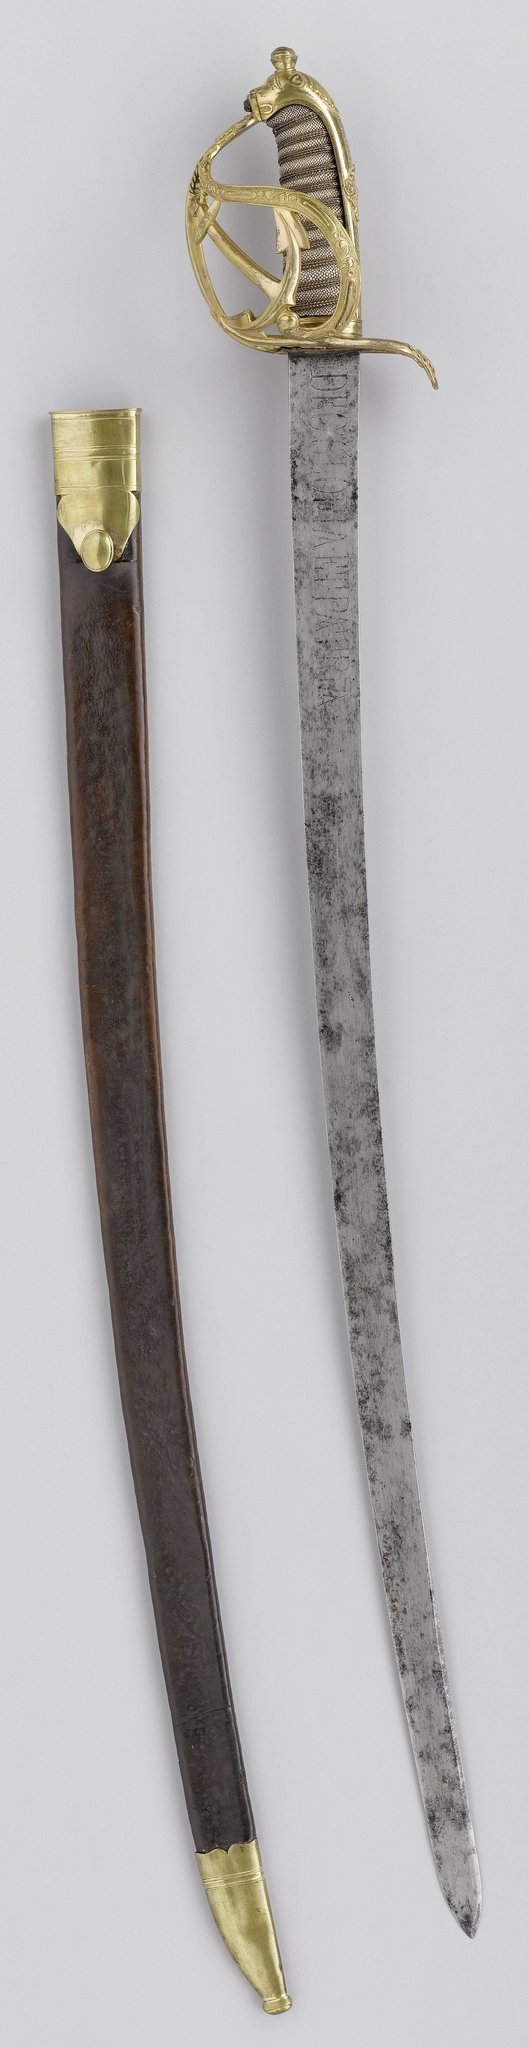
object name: presentation sword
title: Eresabel van Musquetier met opschrift: wegens de Actie van Doggersbank, met schede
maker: abraham scheurleer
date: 1781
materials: copper, iron, leather, skin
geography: the hague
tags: rotterdam, the hague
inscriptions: : ‘DEO GLORIA ET PATRIA’, : ‘Actie van Doggersbank 5 Augt. 1781’, : ‘Abraham Scheurleer a la Haye’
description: Honorary sabre c. 1781 At the reception in Huis ten Bosch a number of officers were honoured by William V with sabres, marking their part in the Battle of Dogger Bank.